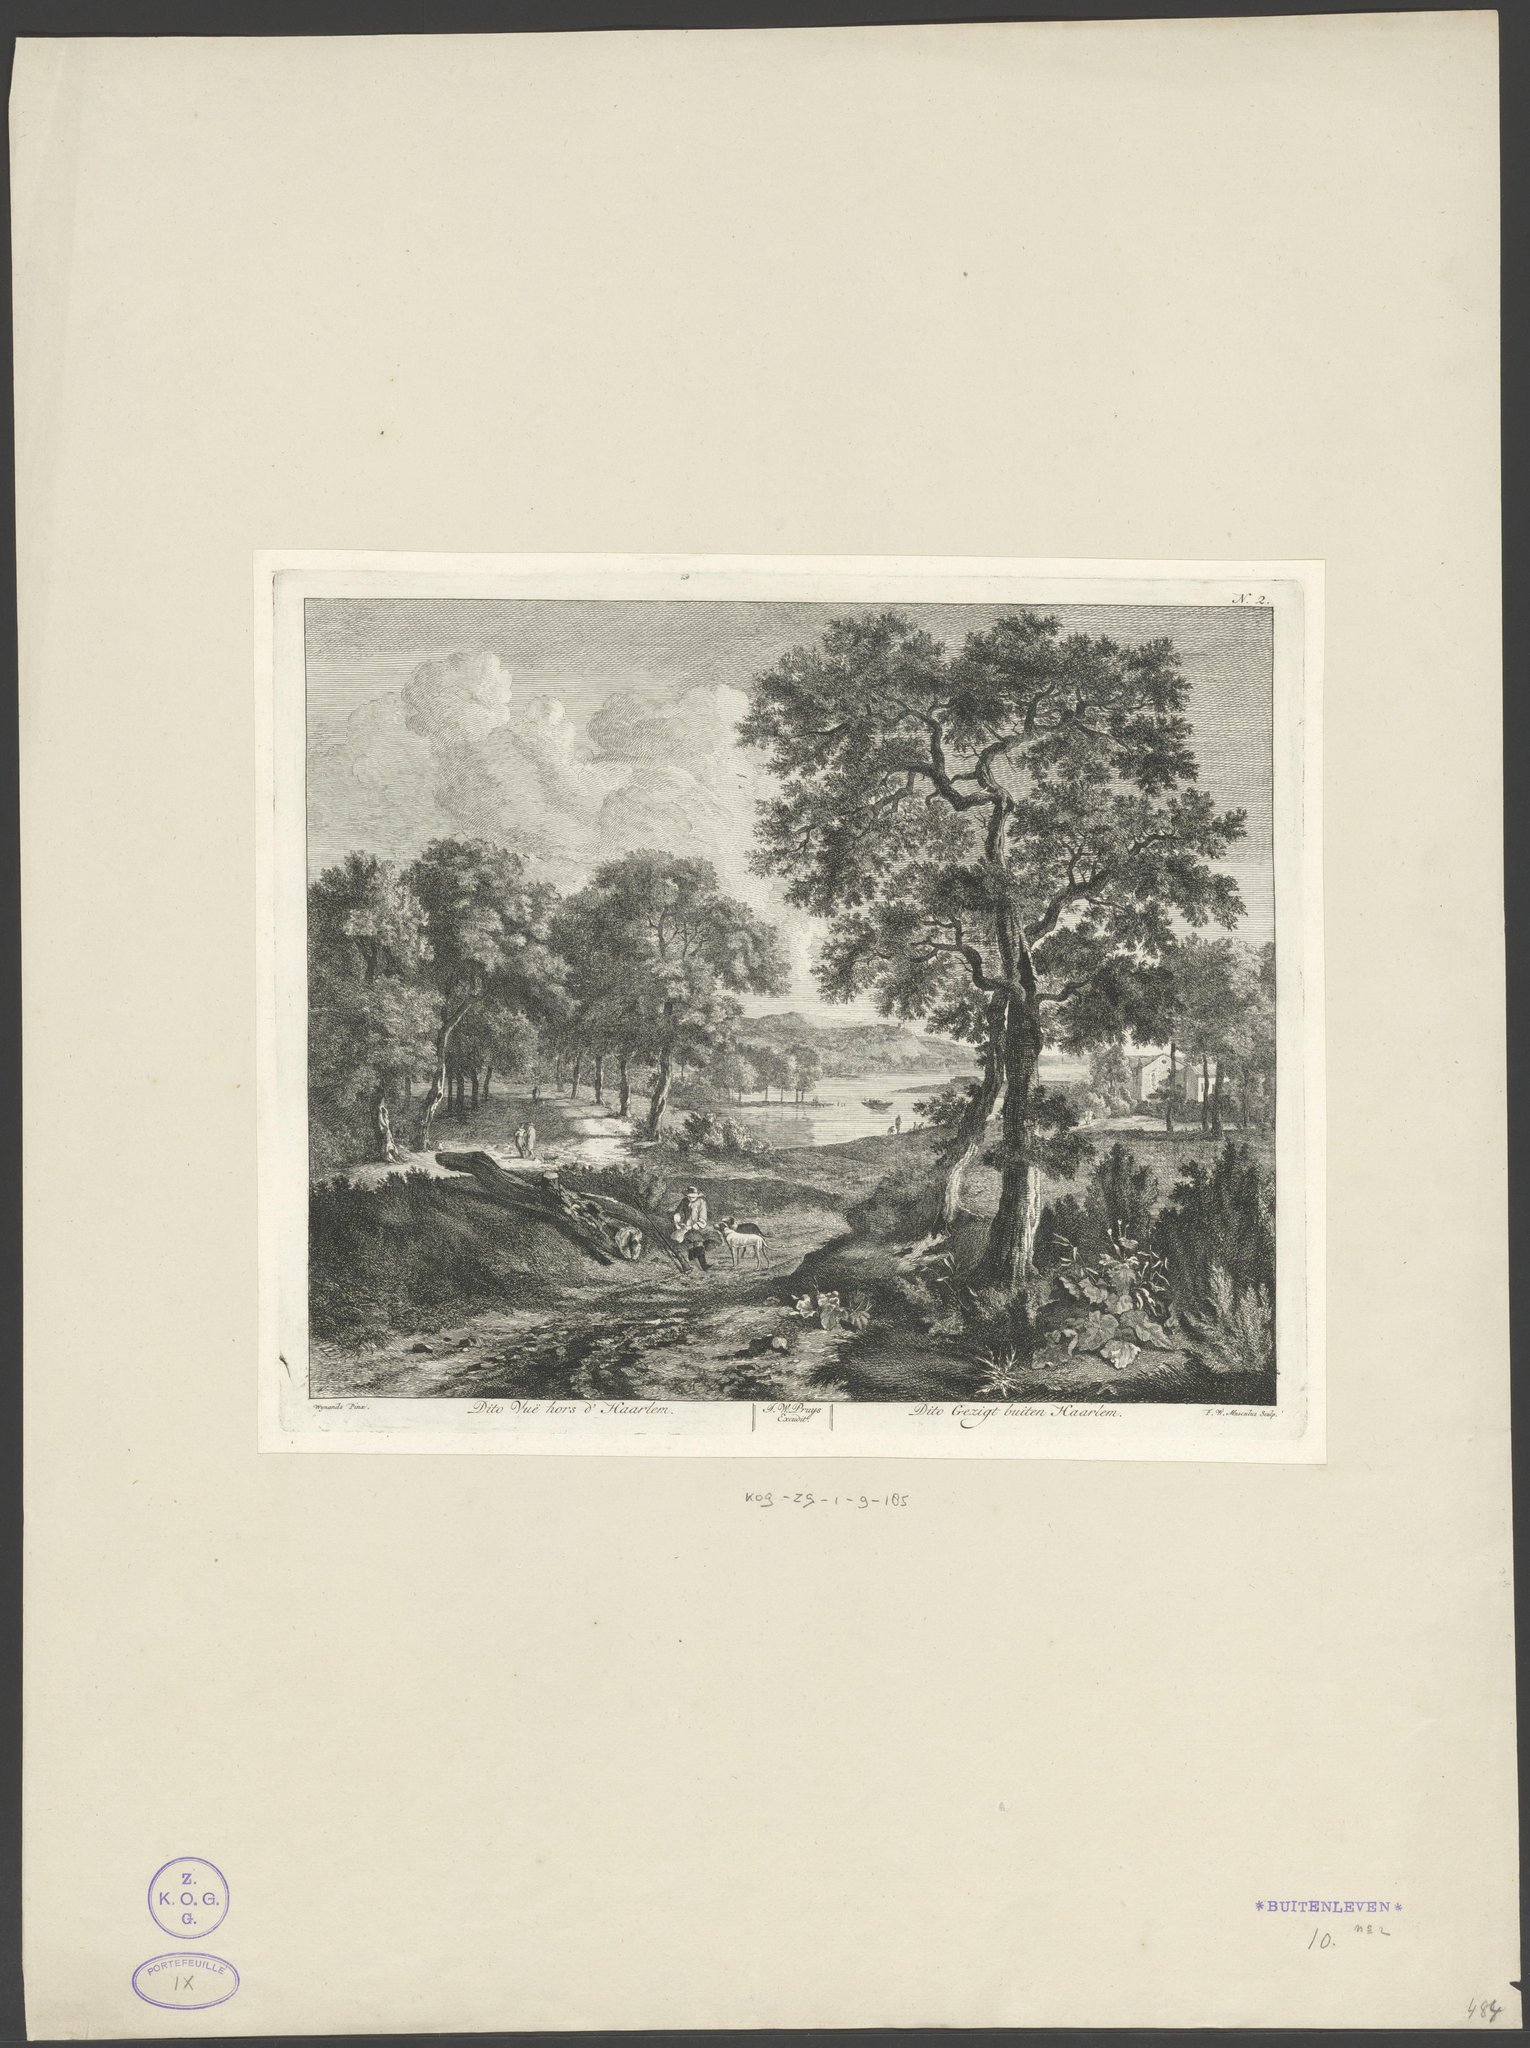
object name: print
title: Dito Vuë hors d'Haarlem / Dito Gezigt buiten Haarlem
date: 1747-1758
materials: paper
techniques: engraving, etching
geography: amsterdam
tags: dune coast, hunting dogs, hunter, haarlem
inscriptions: stamp, stamp, collector's mark: Lugt 1641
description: Duinlandschap buiten Haarlem met een meer op de achtergrond. Op de voorgrond een rustende jager met twee jachthonden. Rechtsboven genummerd: N. 2. Onderwerpsrubrieken binnen de Atlas Zeden en Gewoonten: Handel, nijverheid en verkeer, Buitenleven.